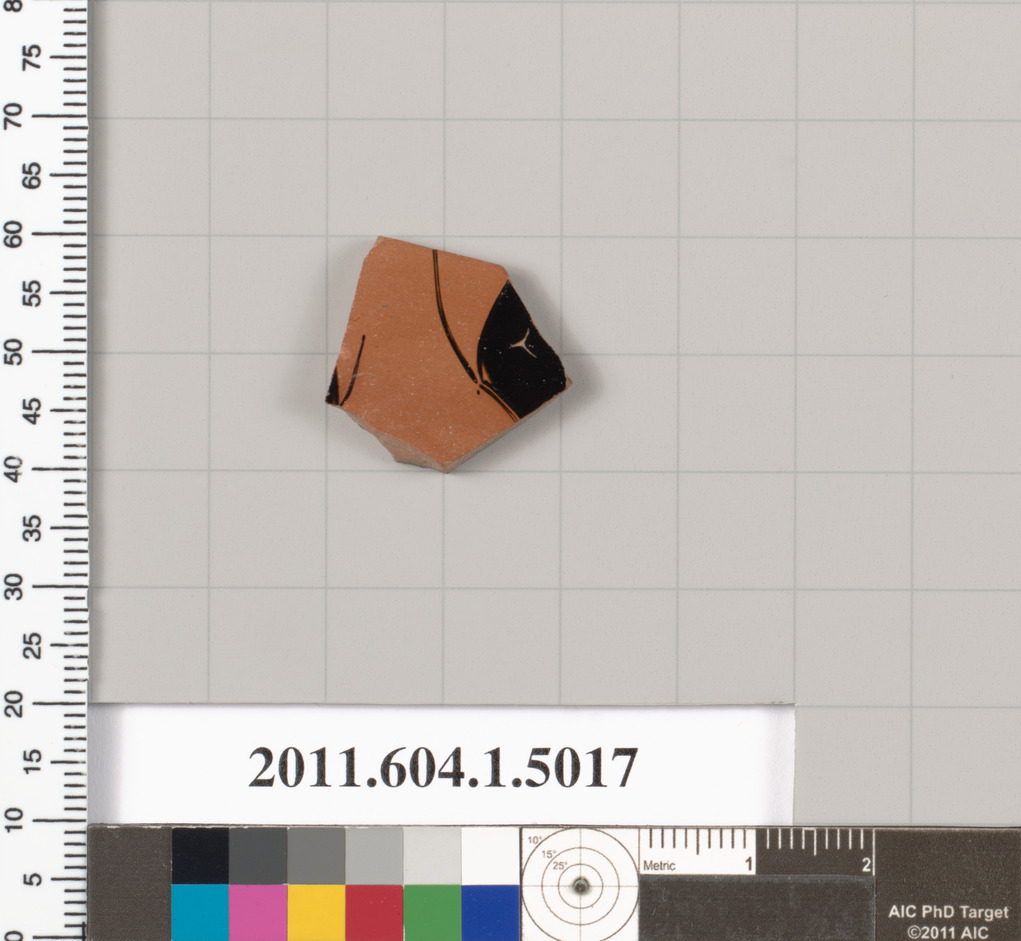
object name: kylix fragment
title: Terracotta fragment of a kylix (drinking cup)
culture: greek, attic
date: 500-480 BCE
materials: terracotta